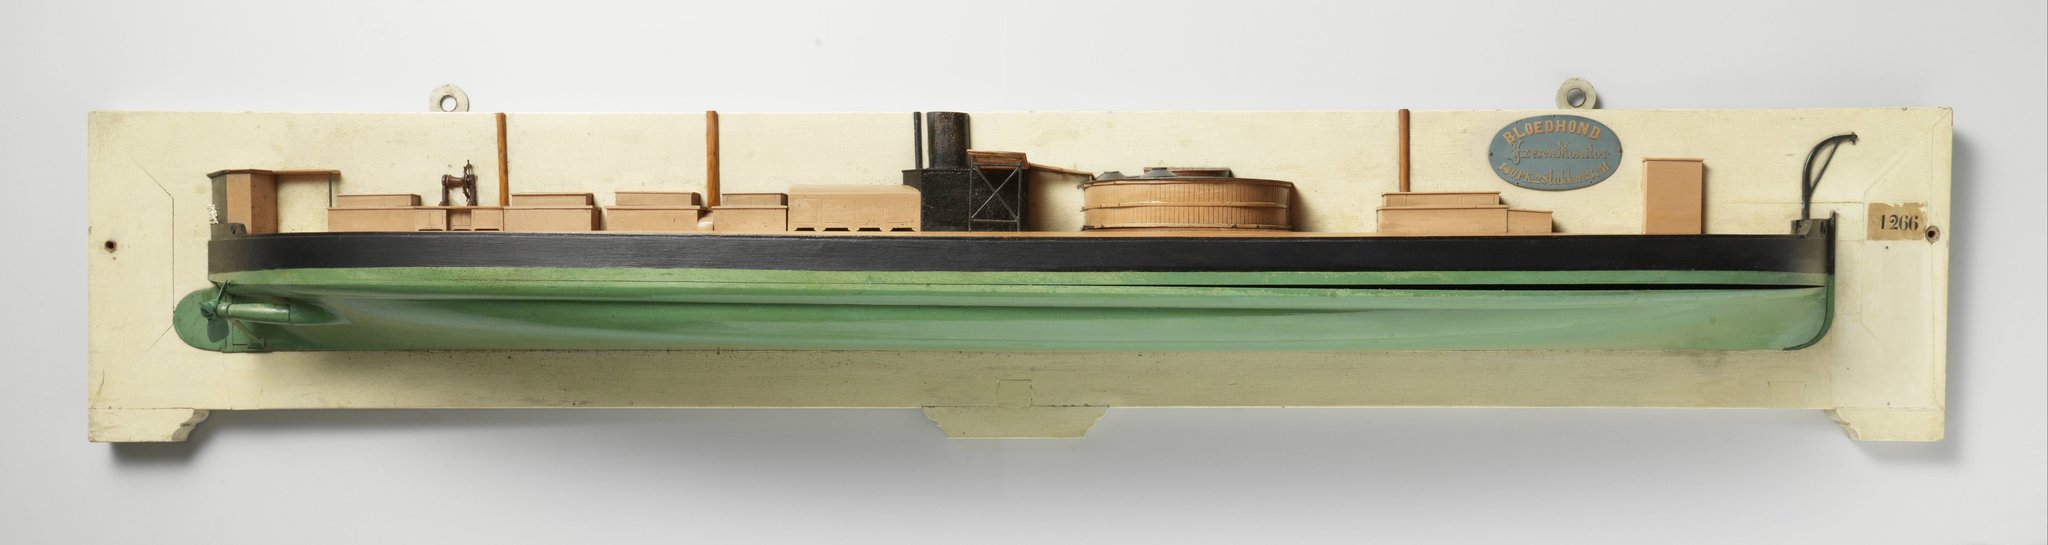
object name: half model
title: Half Model of a Monitor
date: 1867-1869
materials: brass, wood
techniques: polychromy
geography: amsterdam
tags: bloedhond (schip)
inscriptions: inscription, top right, on an oval blue label: ‘BLOEDHOND / Yzeren Monitor / 140 PK: 2 Stukken 23 cm:’, label, bottom right: ‘1266’ former inventory label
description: De monitor Bloedhond, lang 54,80 m, met twee 23 cm kanons, werd in 1867-1869 op de Rijkswerf te Amsterdam gebouwd. Het ontwerp was geïnspireerd op de monitor Tijger. Zij werd in haast afgebouwd en kreeg daarom geen echte dekopbouw. De bewapening werd in 1883 gewijzigd naar een 28 cm kanon, een 7,5 cm kanon, twee 3,7 cm kanons en twee 3,7 cm revolver kanons. Zij deed alleen dienst bij de verdediging van de zeegaten en werd in 1907 voor de sloop verkocht.